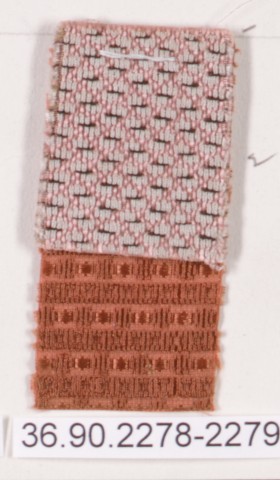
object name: piece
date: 1801-1900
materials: silk